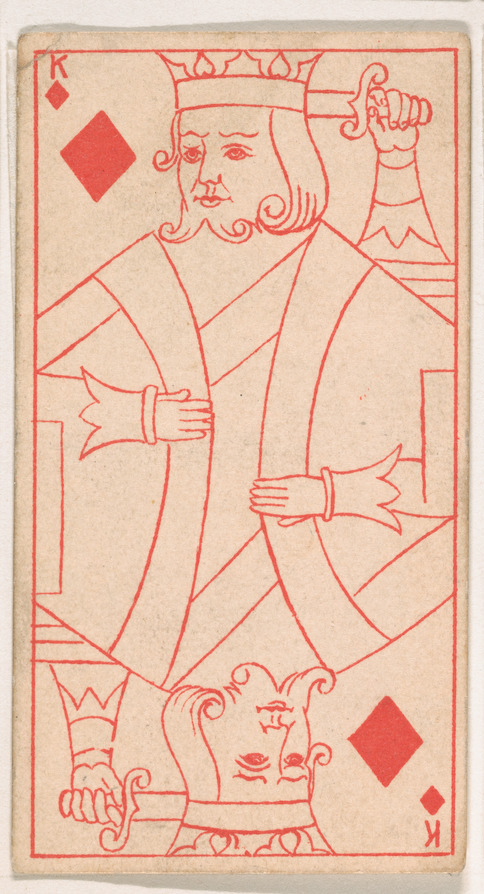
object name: print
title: King of Diamonds, from the Transparent Playing Cards series (N220) issued by Kinney Bros.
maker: kinney brothers tobacco company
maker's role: publisher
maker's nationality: american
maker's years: 1869-2011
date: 1888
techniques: color lithograph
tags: kings,playing cards